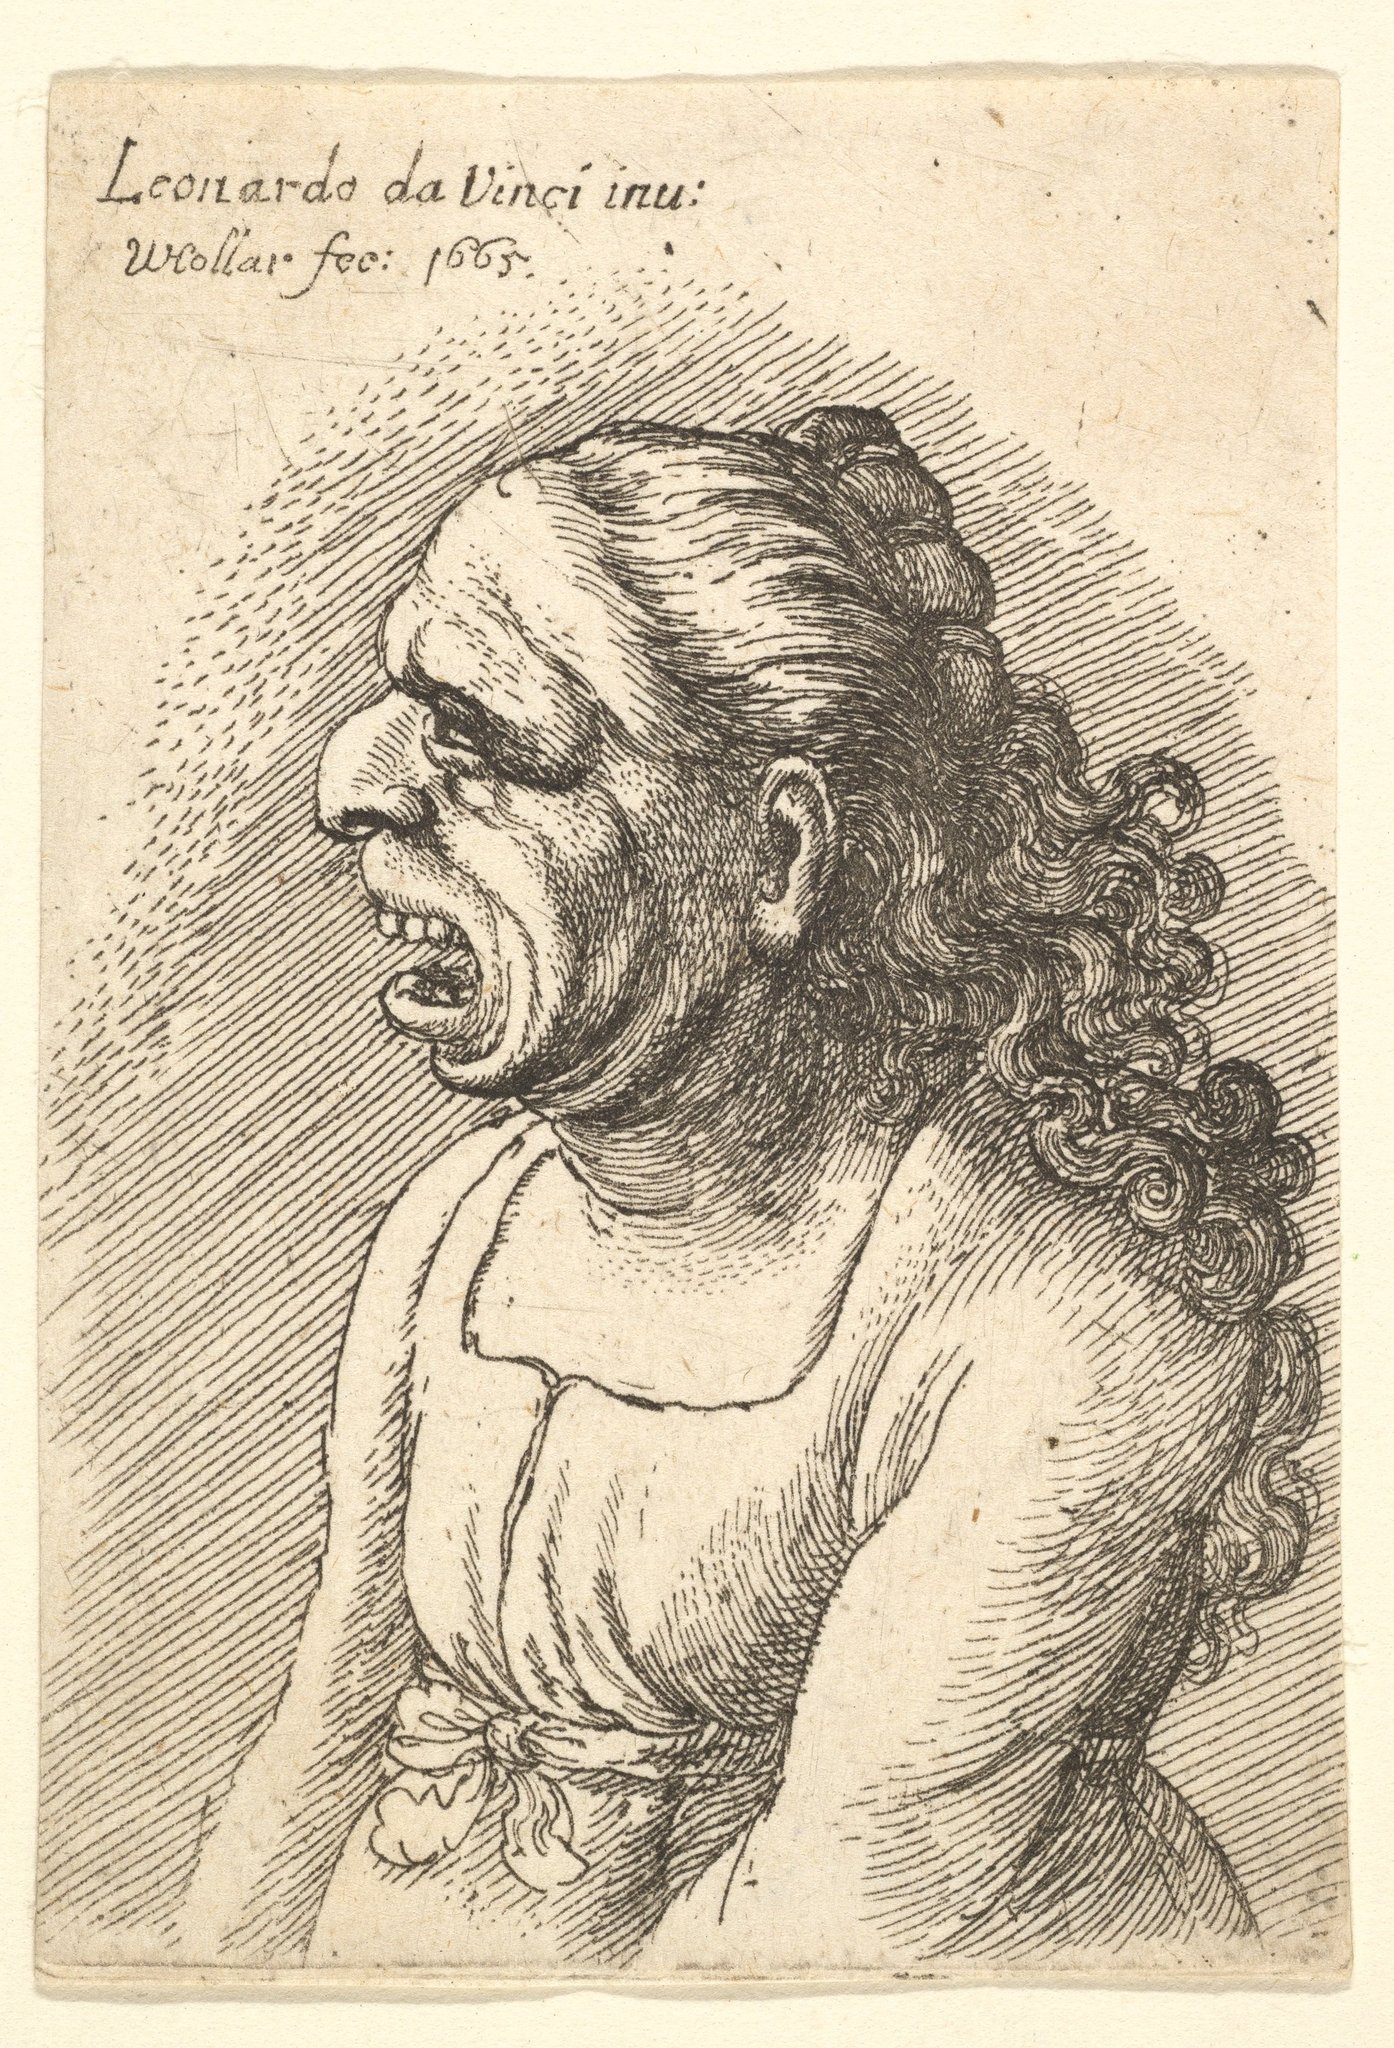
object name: print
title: Bust of woman with wide-open mouth and long curly hair falling over her shoulders, wearing low-cut dress with ribbon round her waist, in profile to left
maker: wenceslaus hollar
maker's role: artist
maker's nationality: bohemian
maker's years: 1607-1677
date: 1665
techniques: etching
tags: women